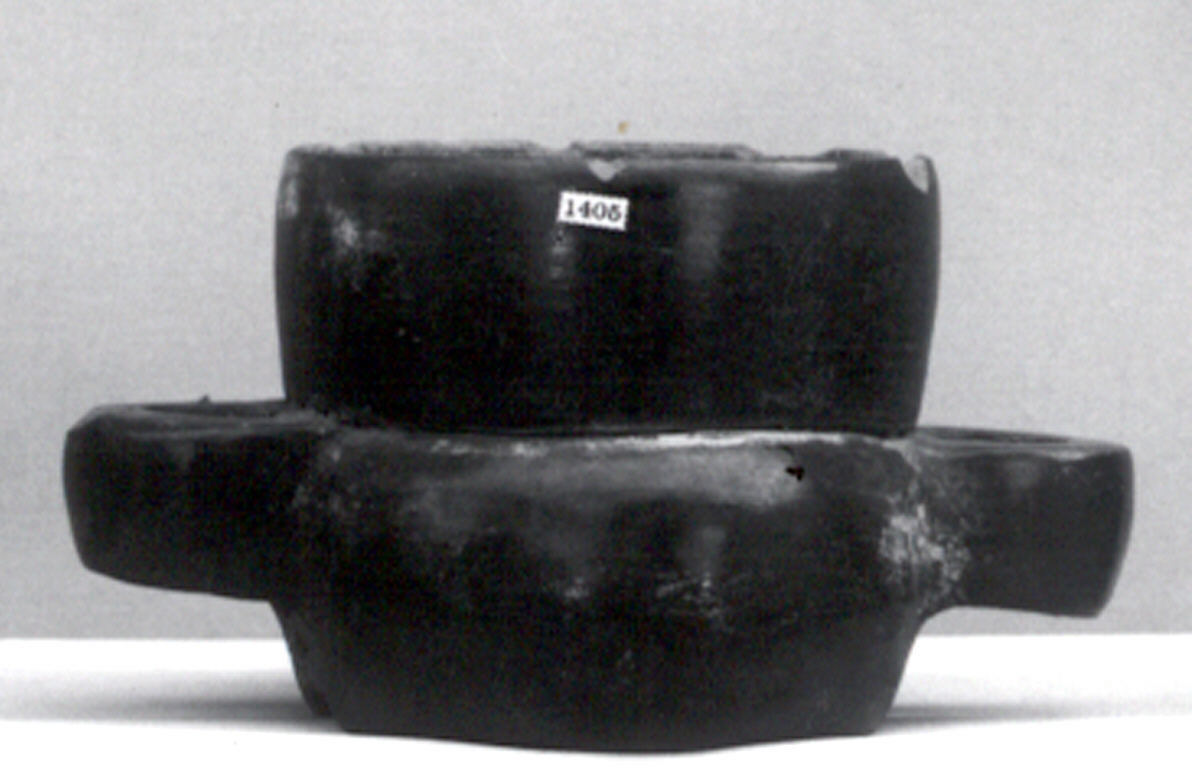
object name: incense burner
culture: mexica, aztec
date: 1301-1600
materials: ceramic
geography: mexico